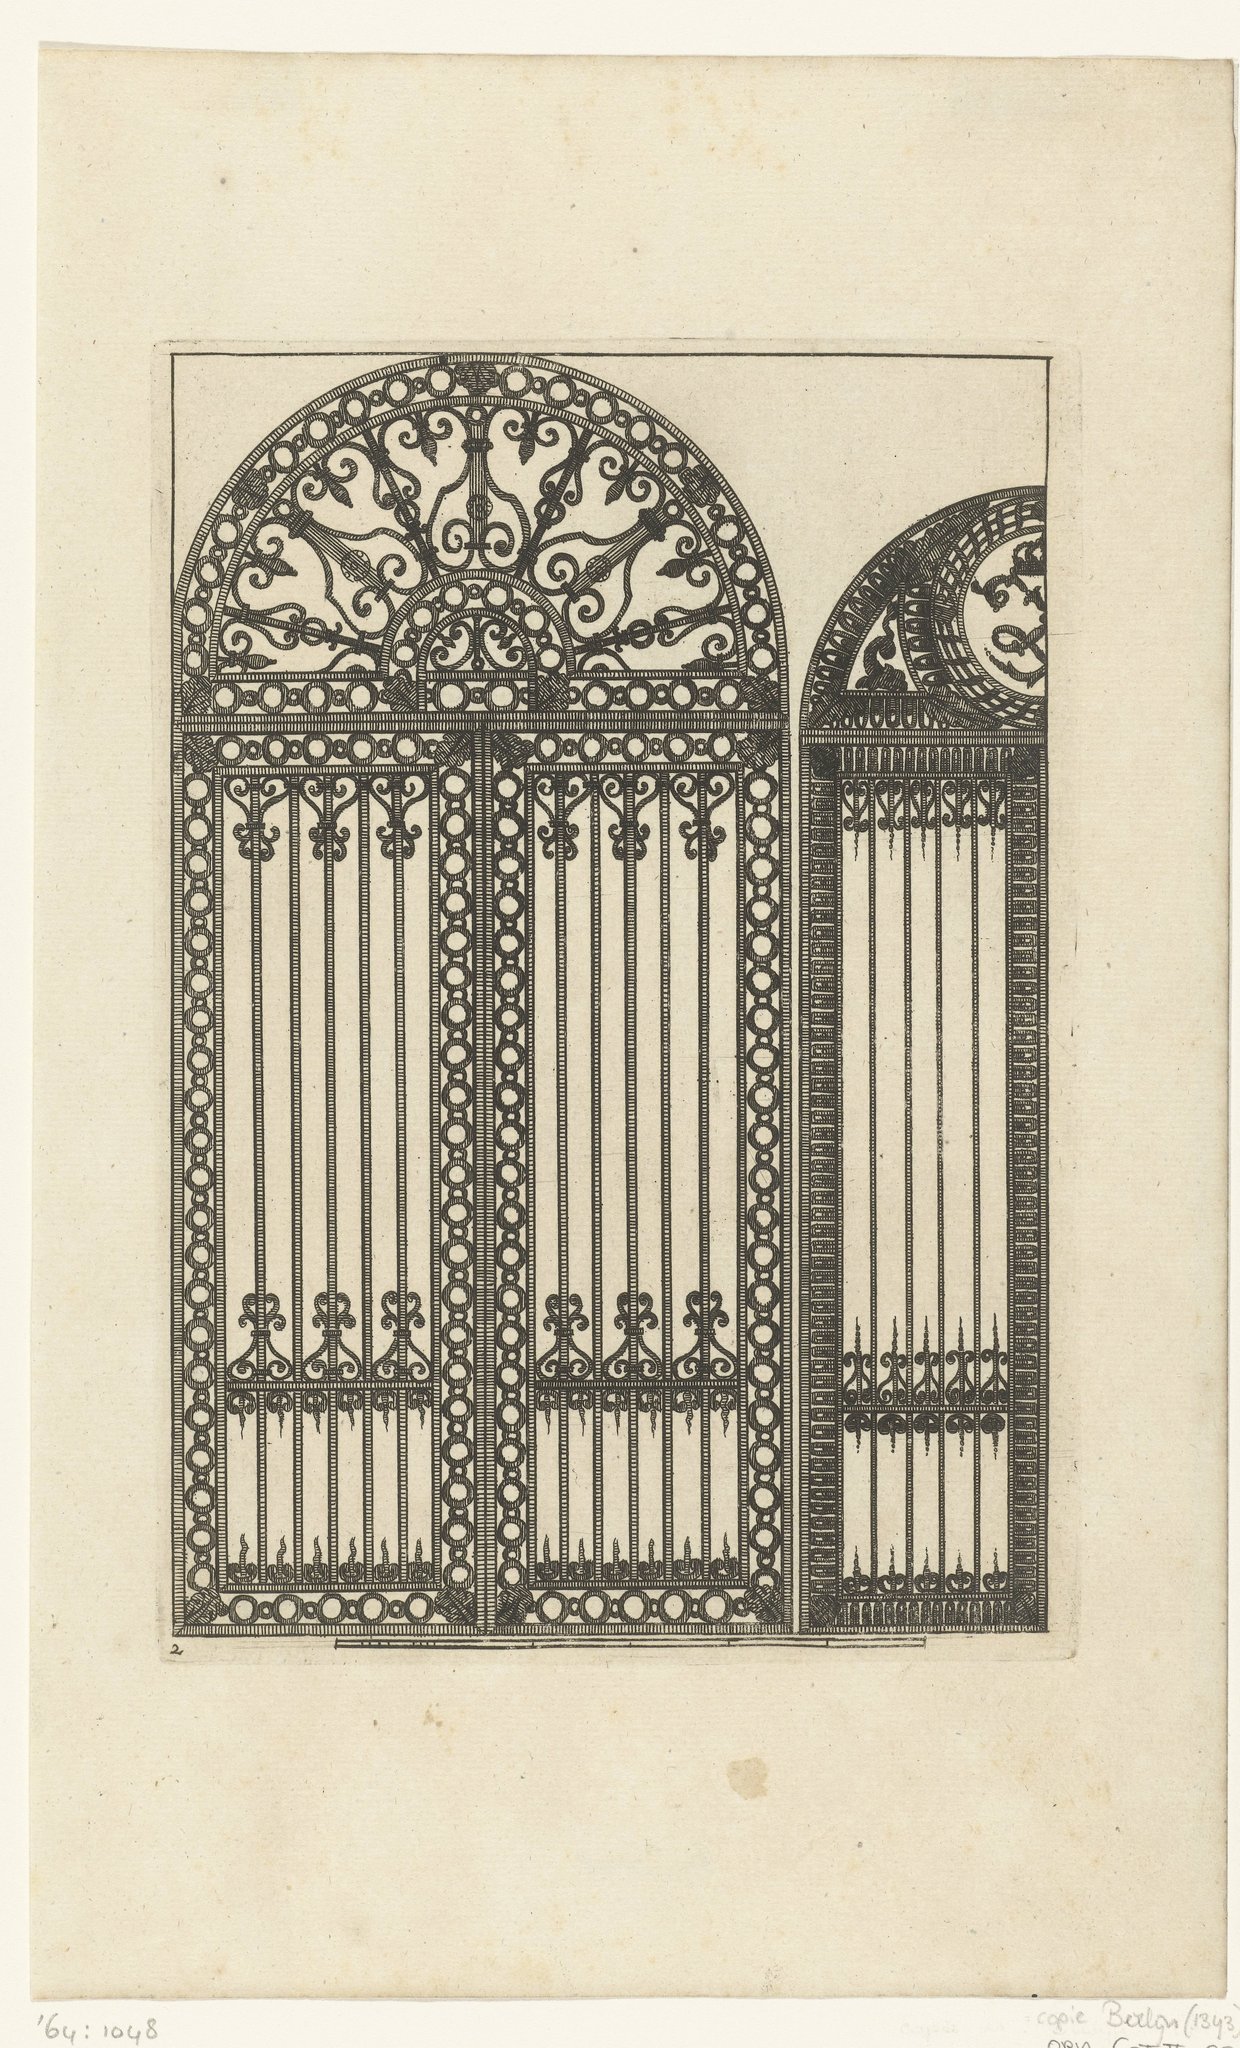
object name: ornament print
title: Hek met variant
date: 1726-1750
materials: paper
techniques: etching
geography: amsterdam